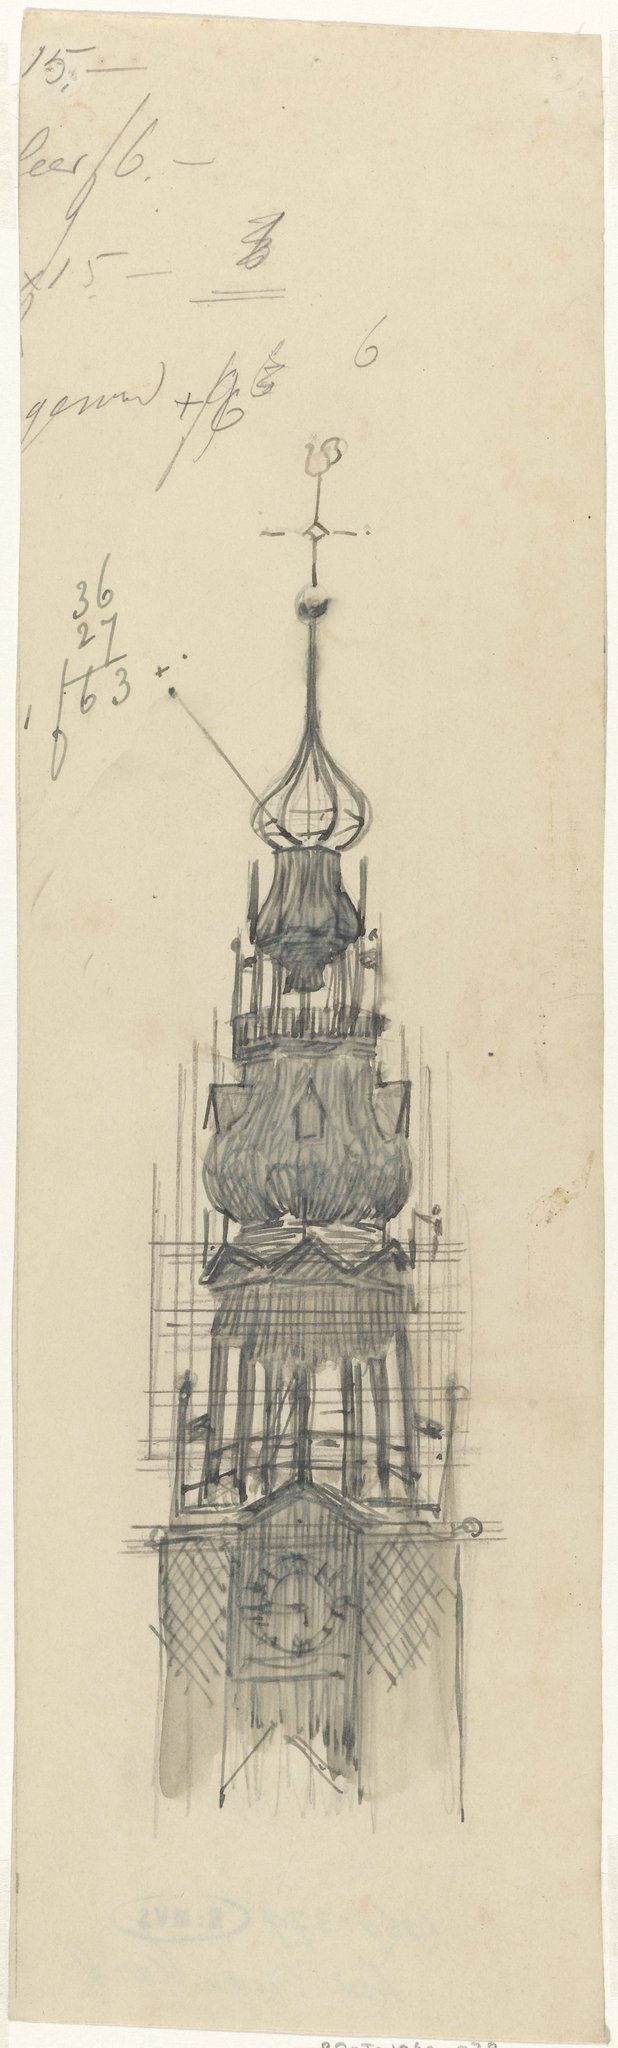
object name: drawing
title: Toren van de Oude Kerk te Amsterdam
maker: carel adolph lion cachet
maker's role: draughtsman, print maker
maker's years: 1864-1945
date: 1874-1945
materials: ink, paper, pencil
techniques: brush, pen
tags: church (exterior), amsterdam